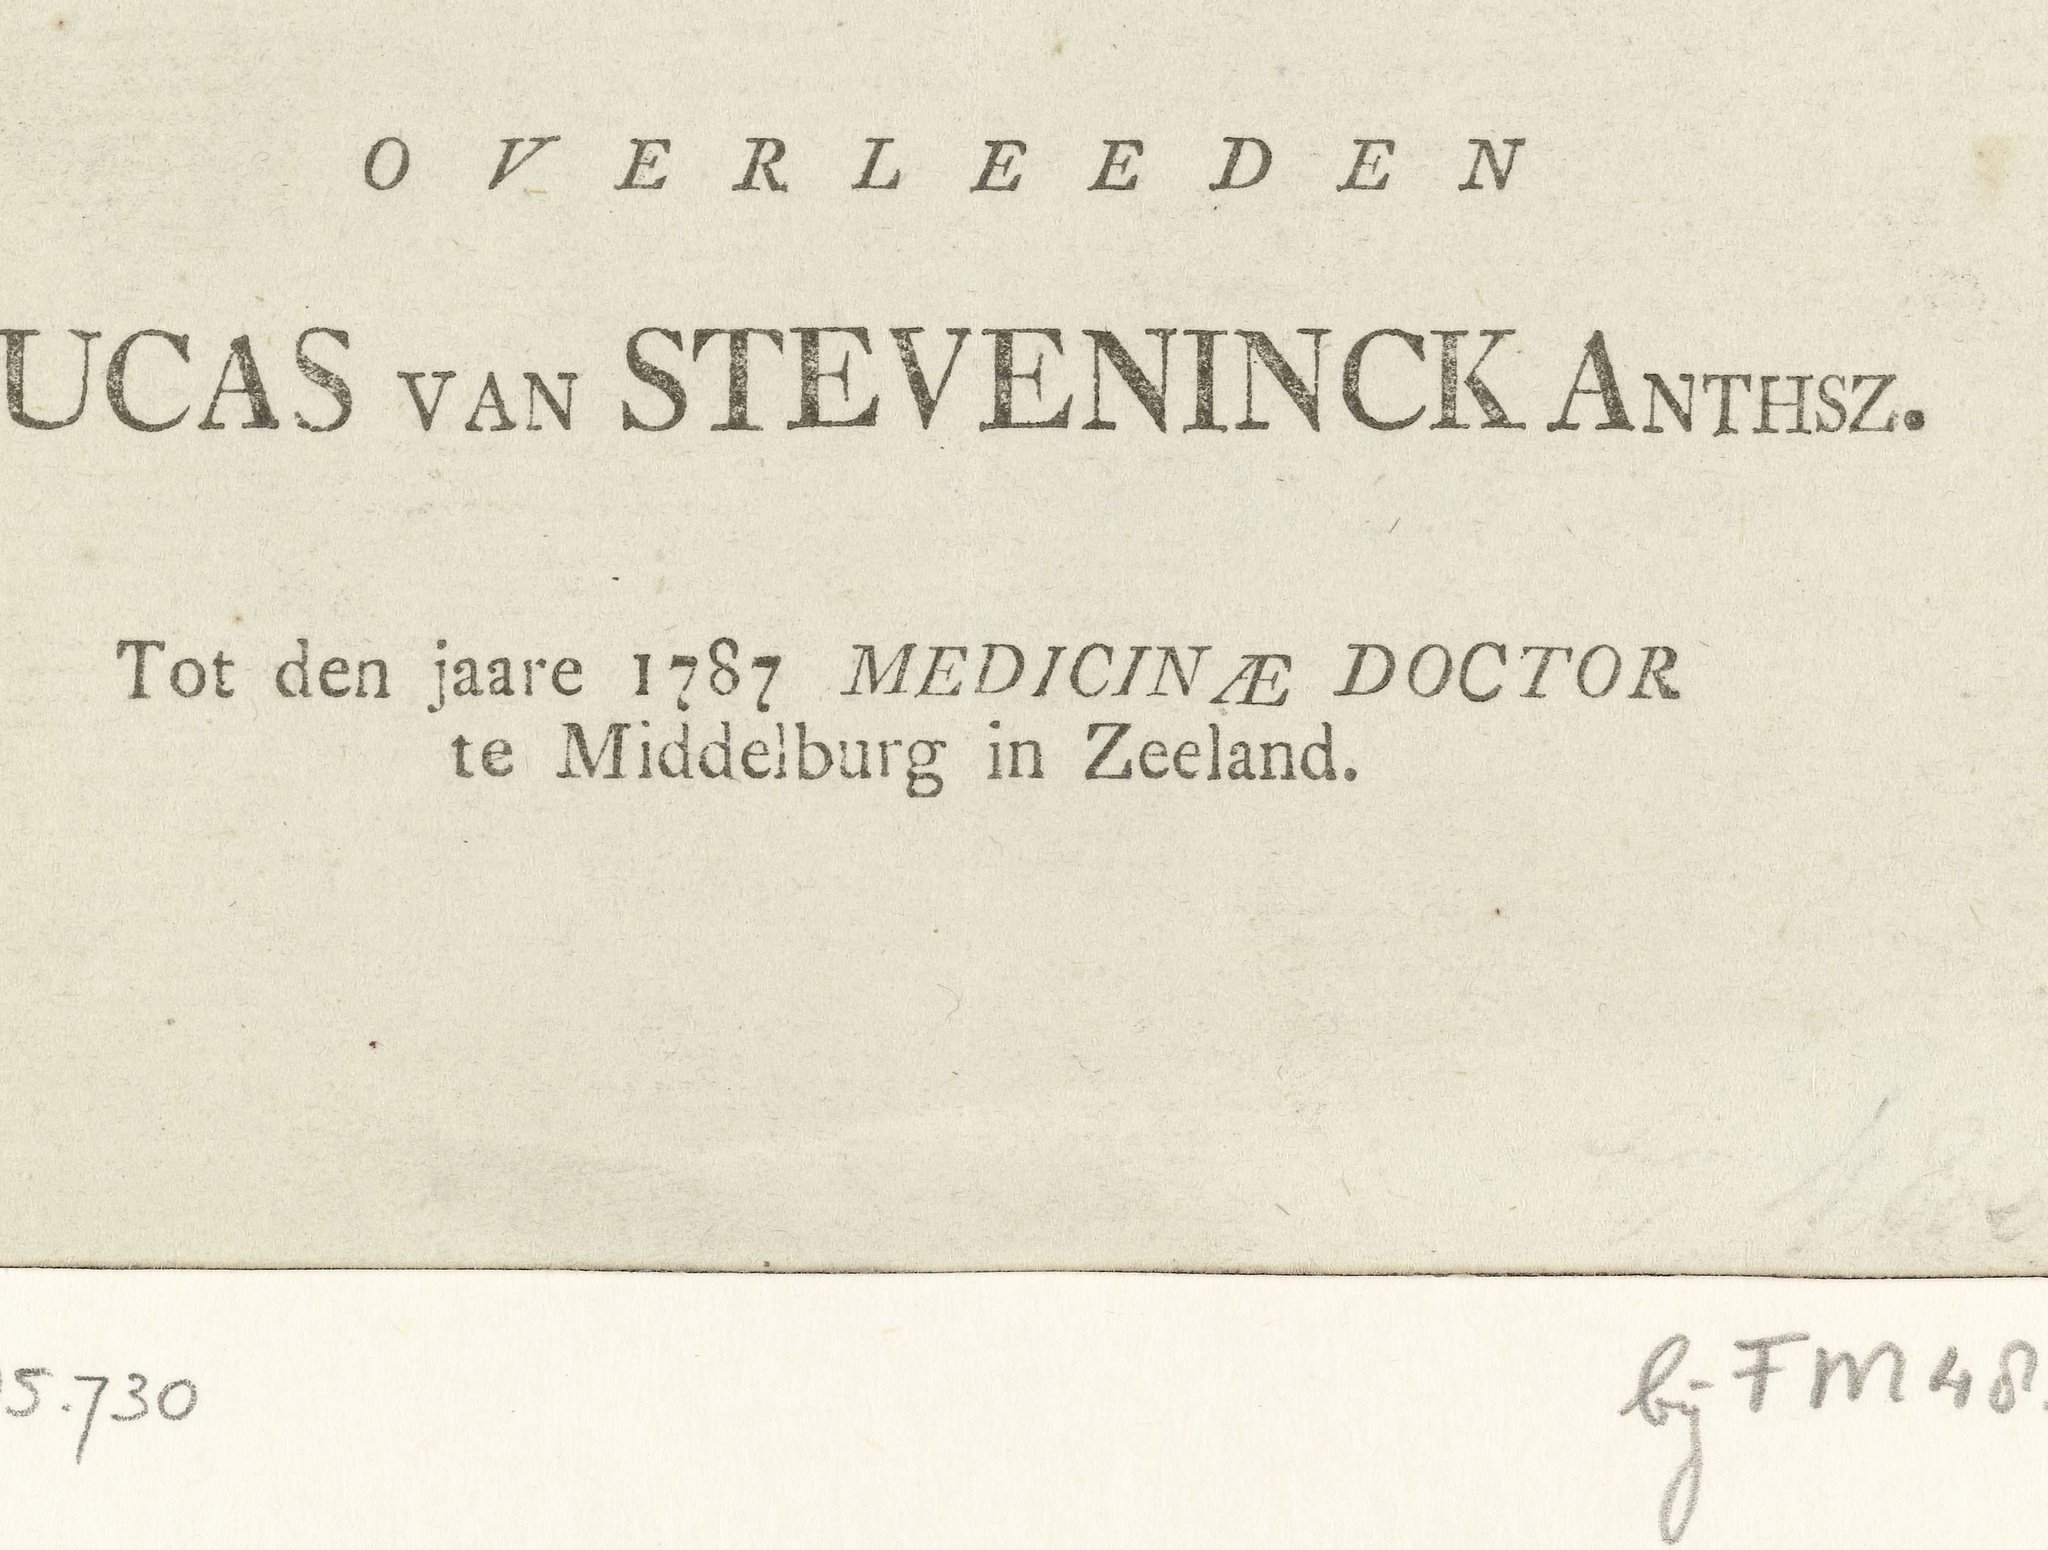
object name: text sheet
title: Doodbriefje van het overlijden van Lucas van Steveninck, 1800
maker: Anonymous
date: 1800-1811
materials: paper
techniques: letterpress printing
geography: amsterdam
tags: middelburg, amsterdam, patriots (1780-1795)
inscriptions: collector's mark: Lugt 2228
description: Blad met de bekendmaking van het overlijden van Lucas van Steveninck te Amsterdam op 1 november 1800.